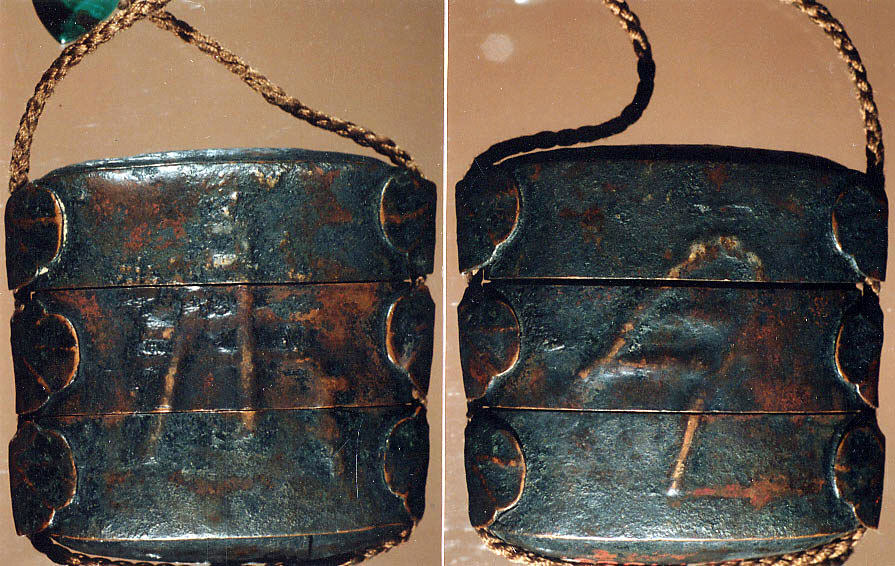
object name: inrō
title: Case (Inrō) with Design of a Stylized Archaic Character in Relief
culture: japanese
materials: copper, cord, lacquer, metal, patina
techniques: embossing, relief